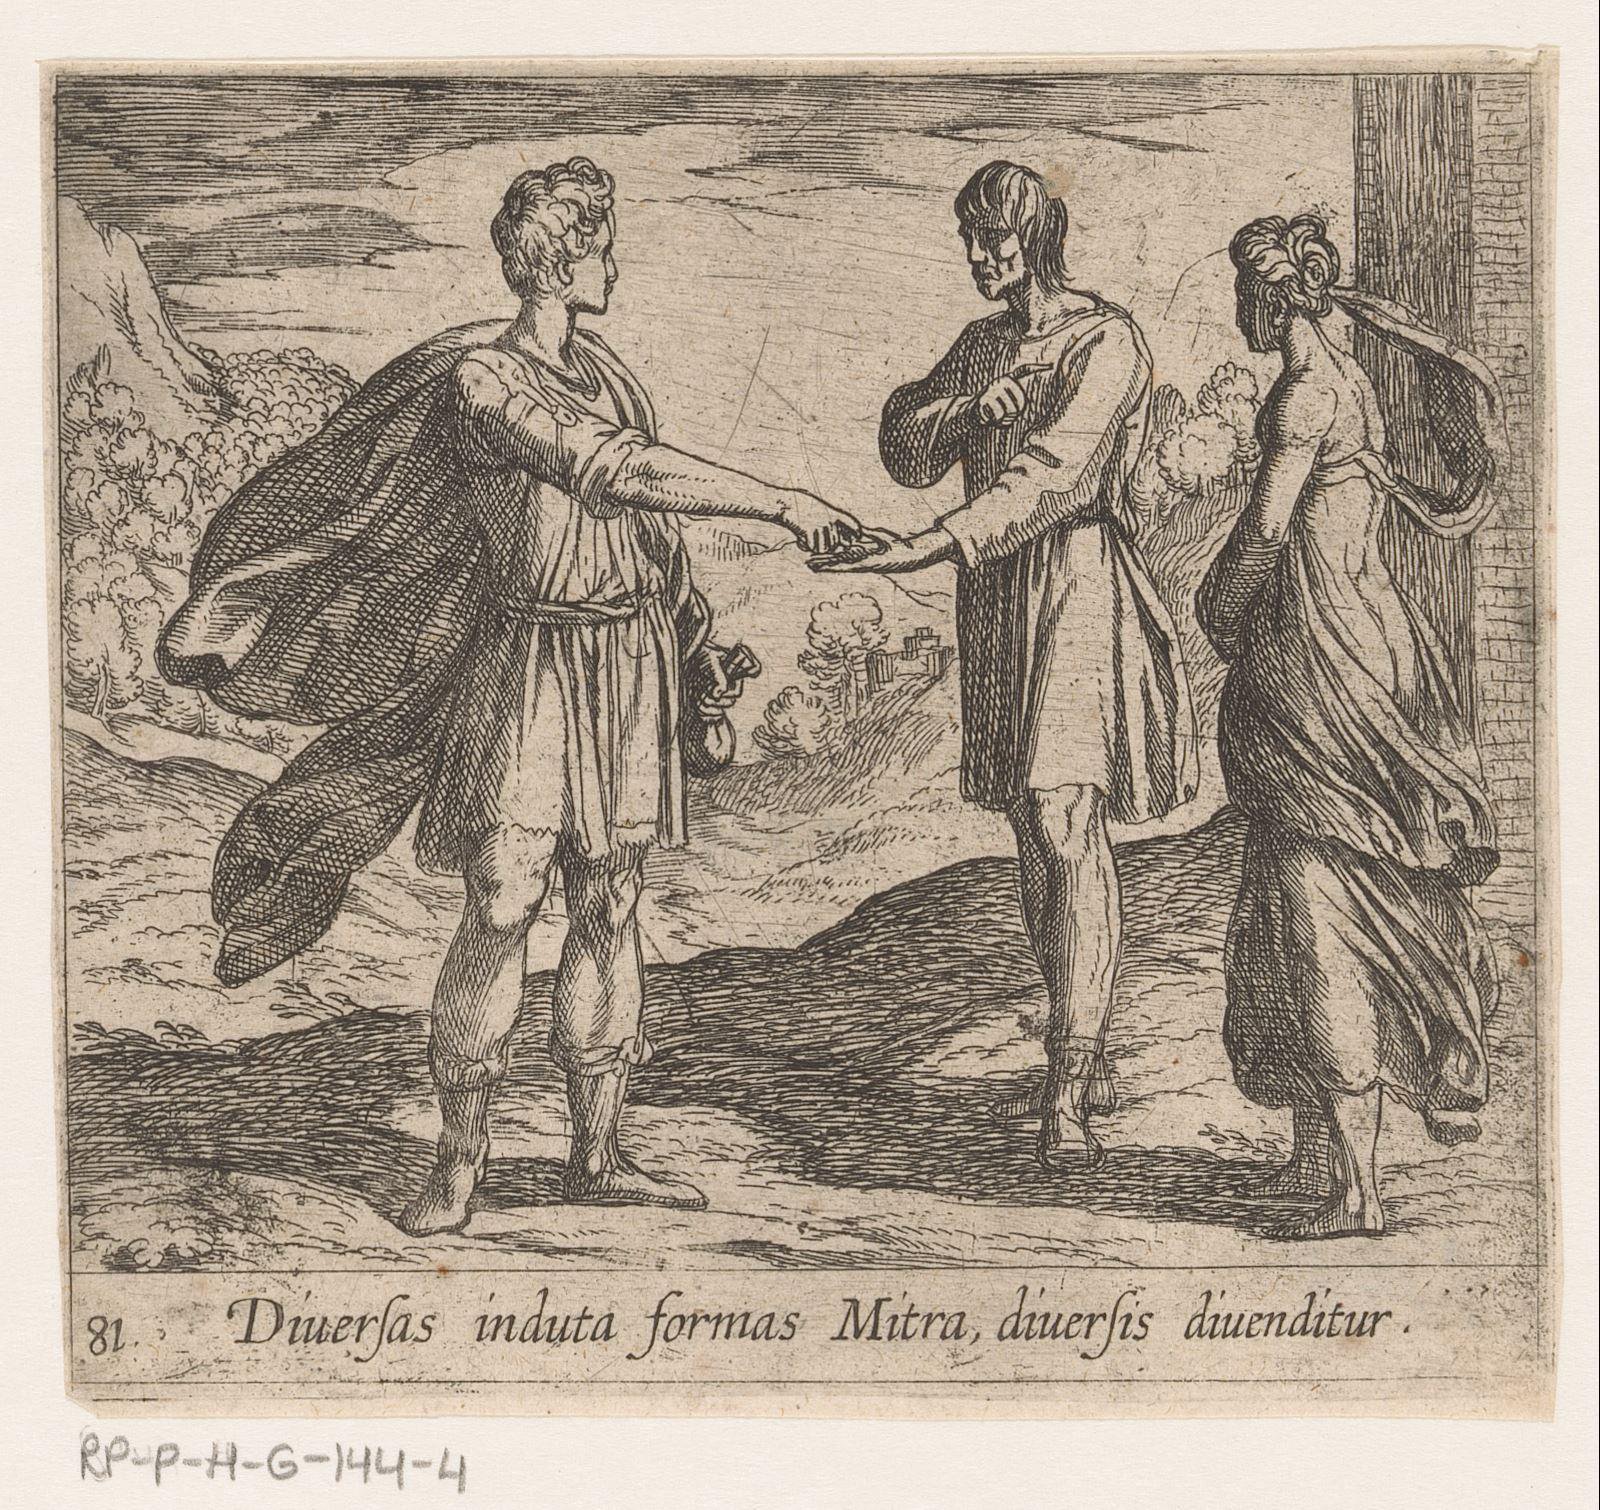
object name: print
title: Metamorfosen van Ovidius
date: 1606-1638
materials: paper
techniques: etching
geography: italy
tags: erysichthon, having squandered all his possessions, is supported by his daughter metra, who lets herself be sold in various forms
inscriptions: collector's mark: ‘Hinloopen’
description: Deze prent maakt deel uit van een reeks van 150 prenten (+ titelprent) met voorstellingen van de Metamorfosen van Ovidius.